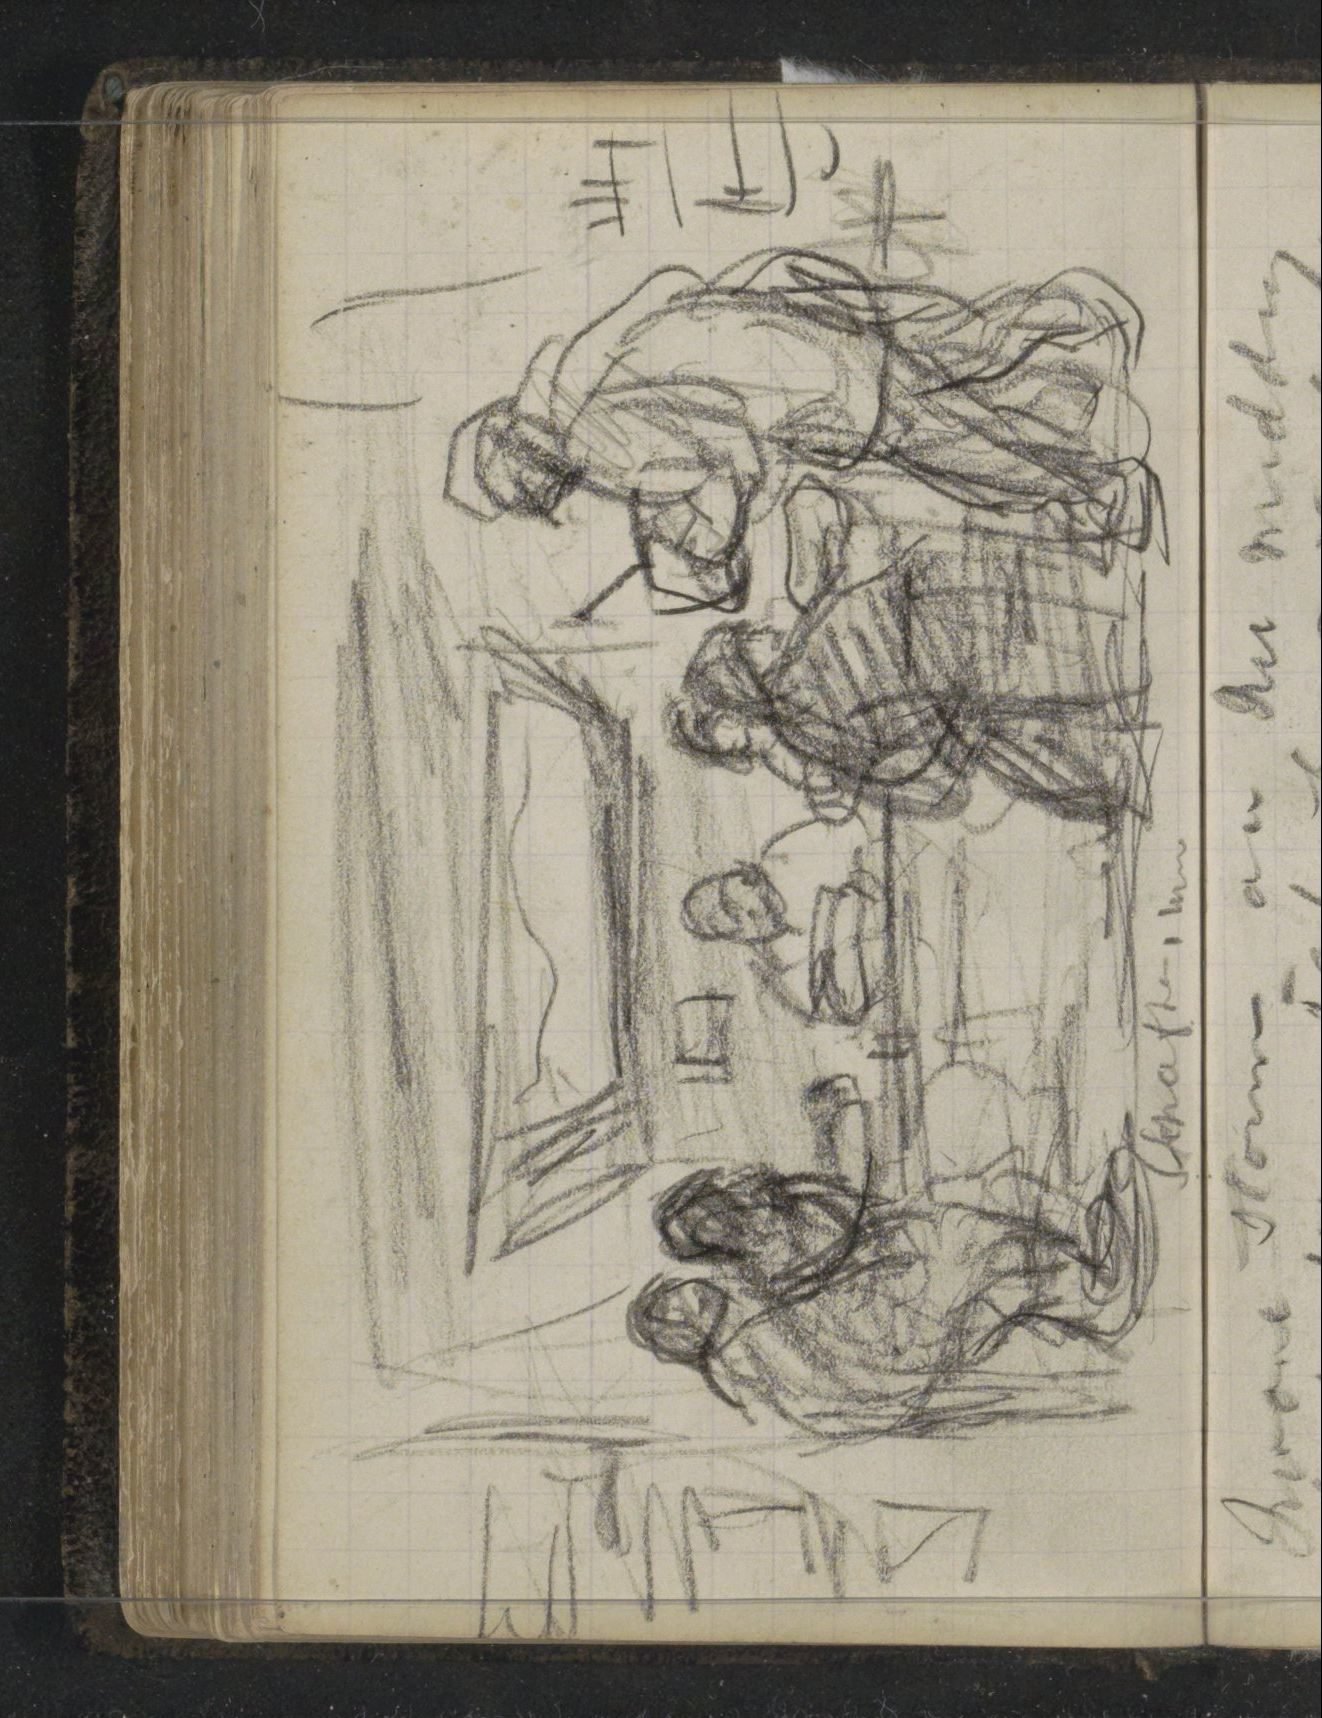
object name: sketchbook leaf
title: Schaftende bemanningsleden van de Willem Barentsz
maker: louis apol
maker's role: draughtsman, painter, print maker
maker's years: 1850-1936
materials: chalk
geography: novaya zemlya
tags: crew ~ ship, interior of the house, midday meal, lunch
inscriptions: annotation: ‘schaften [...]’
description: Blad 79 verso uit een schetsboek met 110 bladen betekend tijdens de expeditie naar Nova Zembla in 1880.